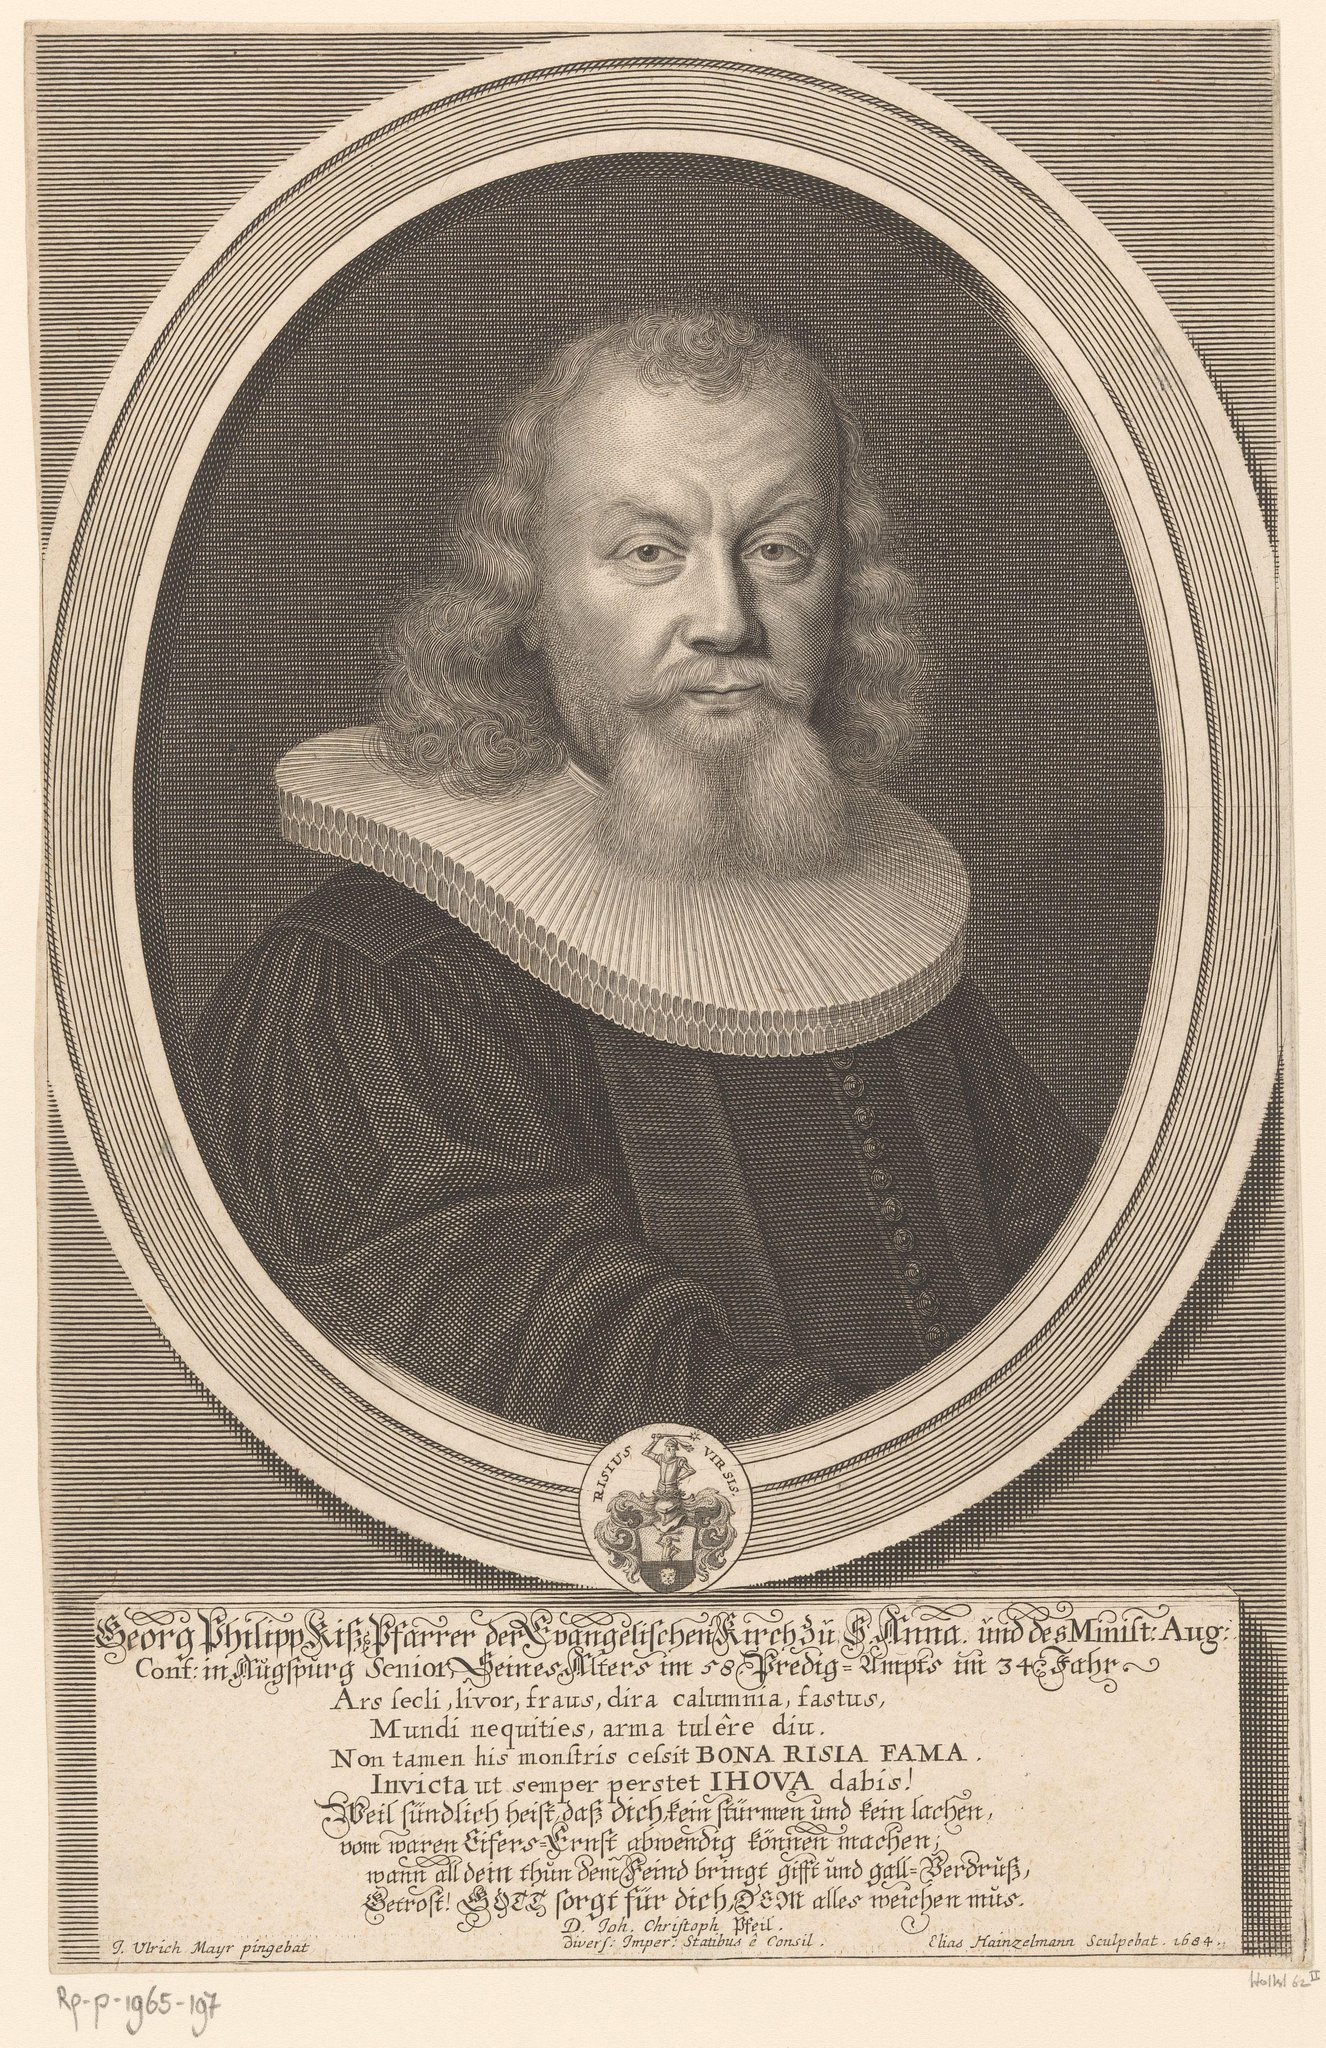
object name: print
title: Portret van Georg Philipp Ris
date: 1684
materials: paper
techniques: engraving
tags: georg philipp ris, historical persons, armorial bearing, heraldry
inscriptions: collector's mark: Lugt 2760, collector's mark: Lugt 2228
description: Met lofdicht in het Latijn en het Duits.